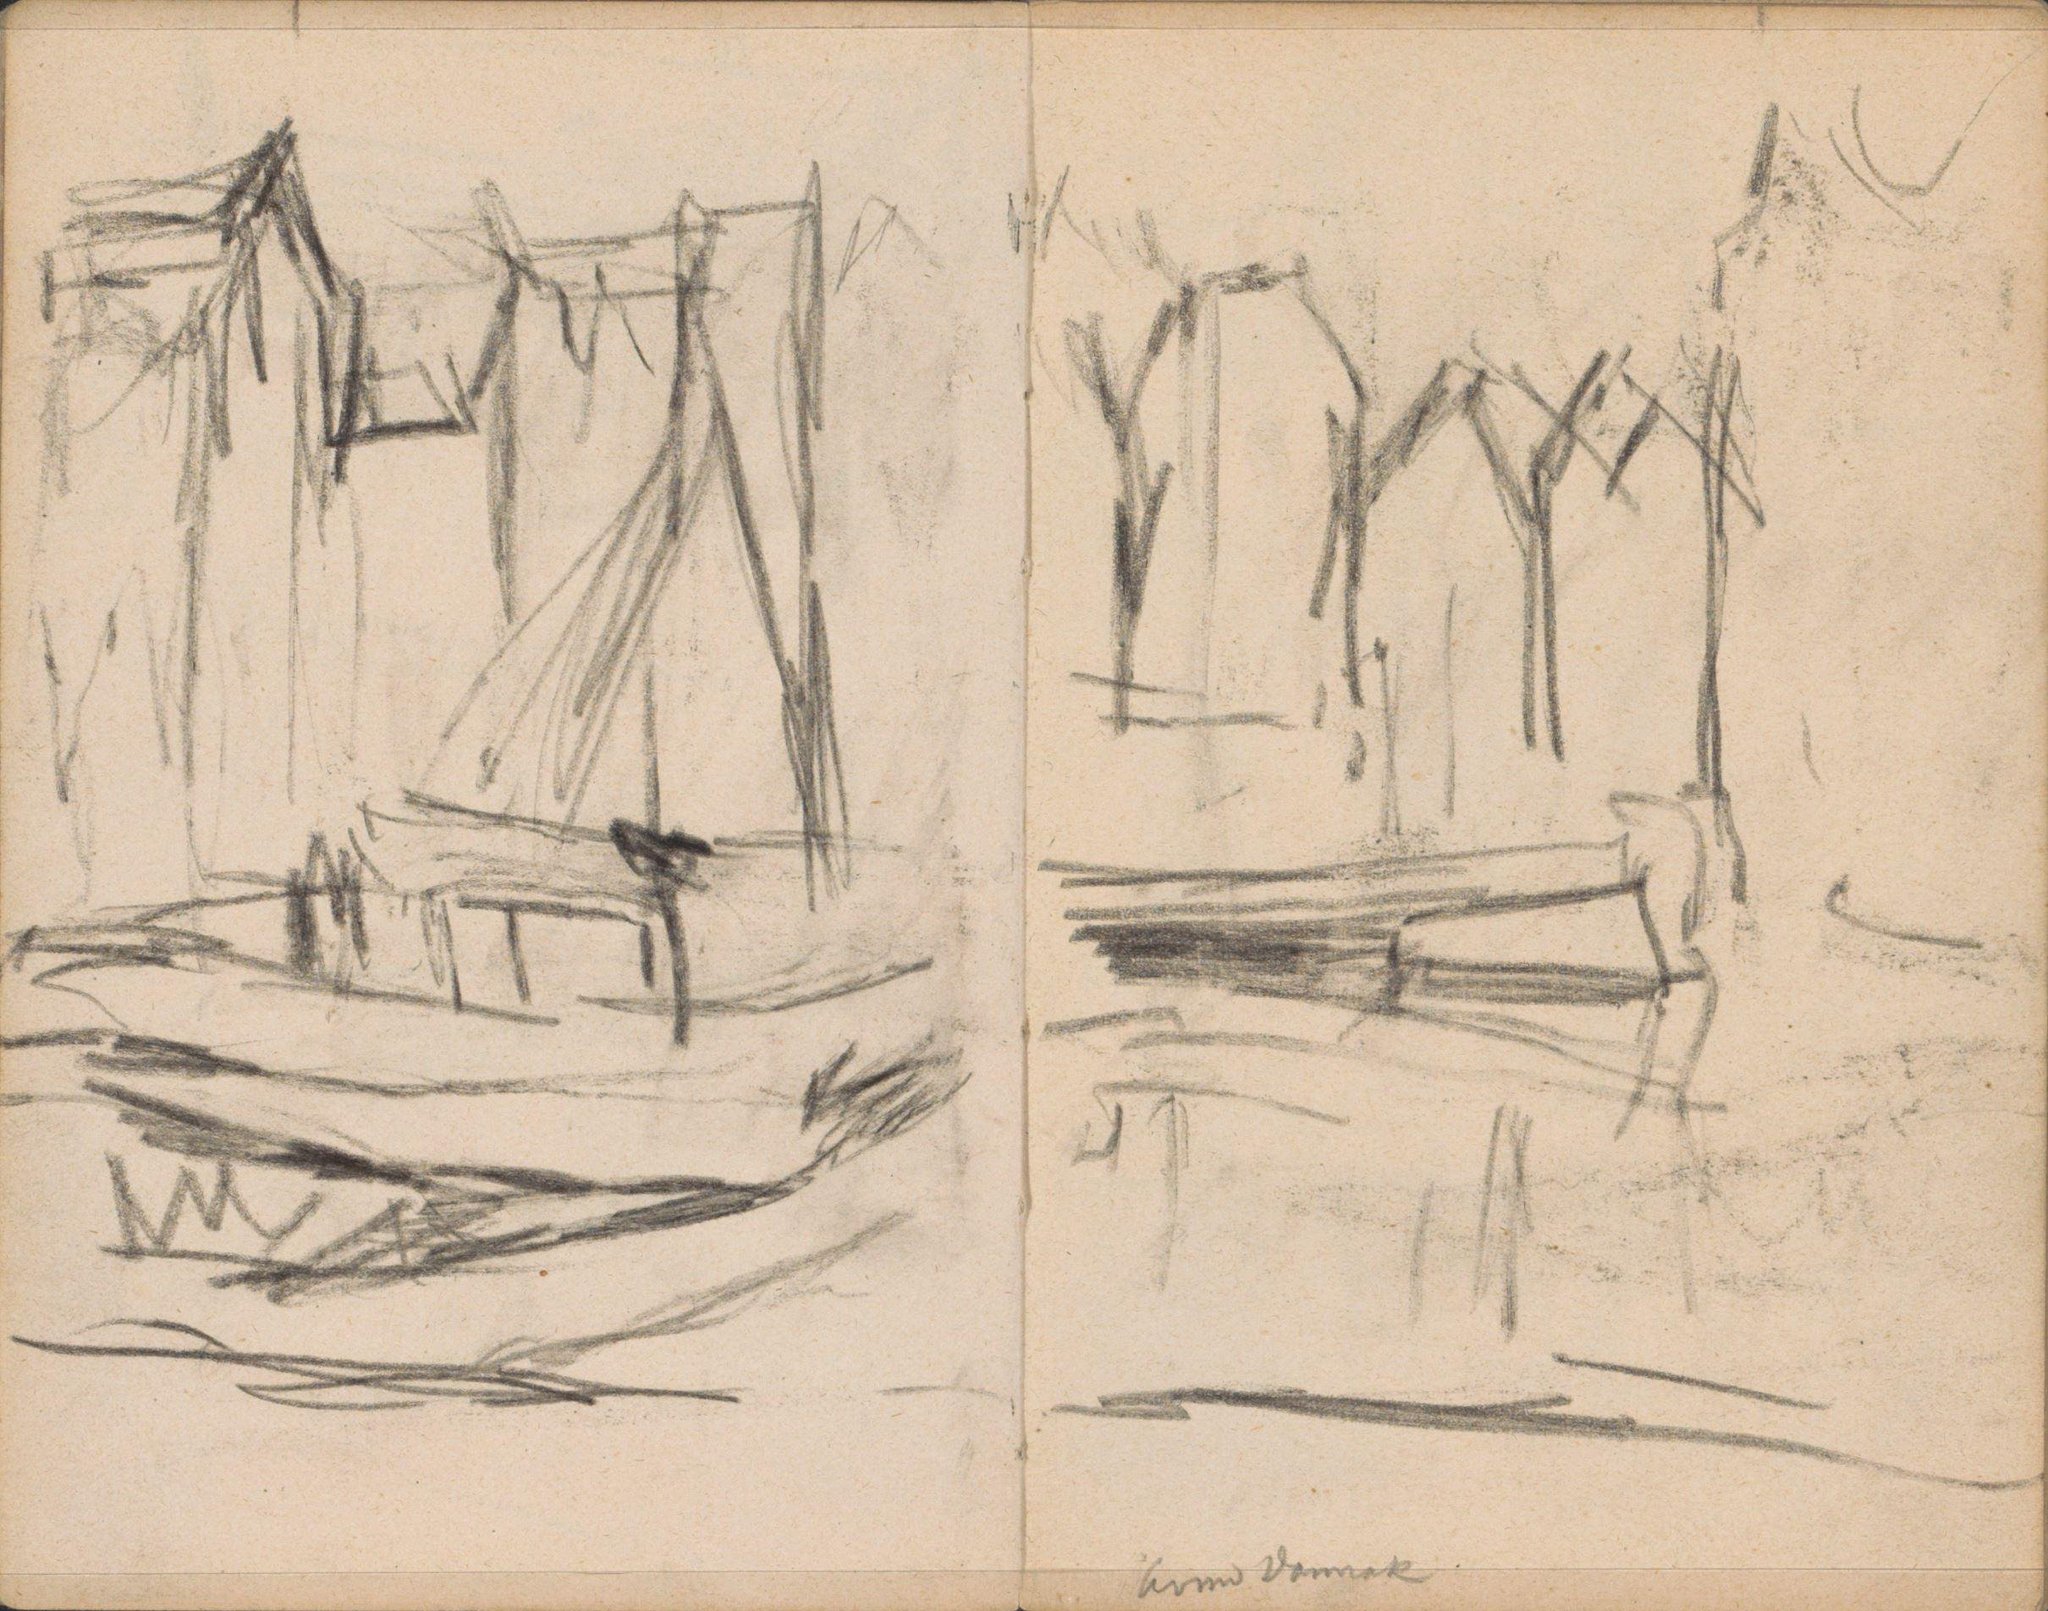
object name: sketchbook leaf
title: Gezicht op het Damrak te Amsterdam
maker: george hendrik breitner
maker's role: draughtsman, painter, print maker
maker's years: 1857-1923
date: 1907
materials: chalk, paper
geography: amsterdam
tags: urban housing, ships (in general), canals, waters (in city)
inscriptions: annotation: ‘Avond[?] damrak’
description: Gezicht op het Damrak te Amsterdam. Pagina 13 en pagina 14 uit een schetsboek met 46 bladen vervaardigd in Amsterdam, Rotterdam en Haarlem.